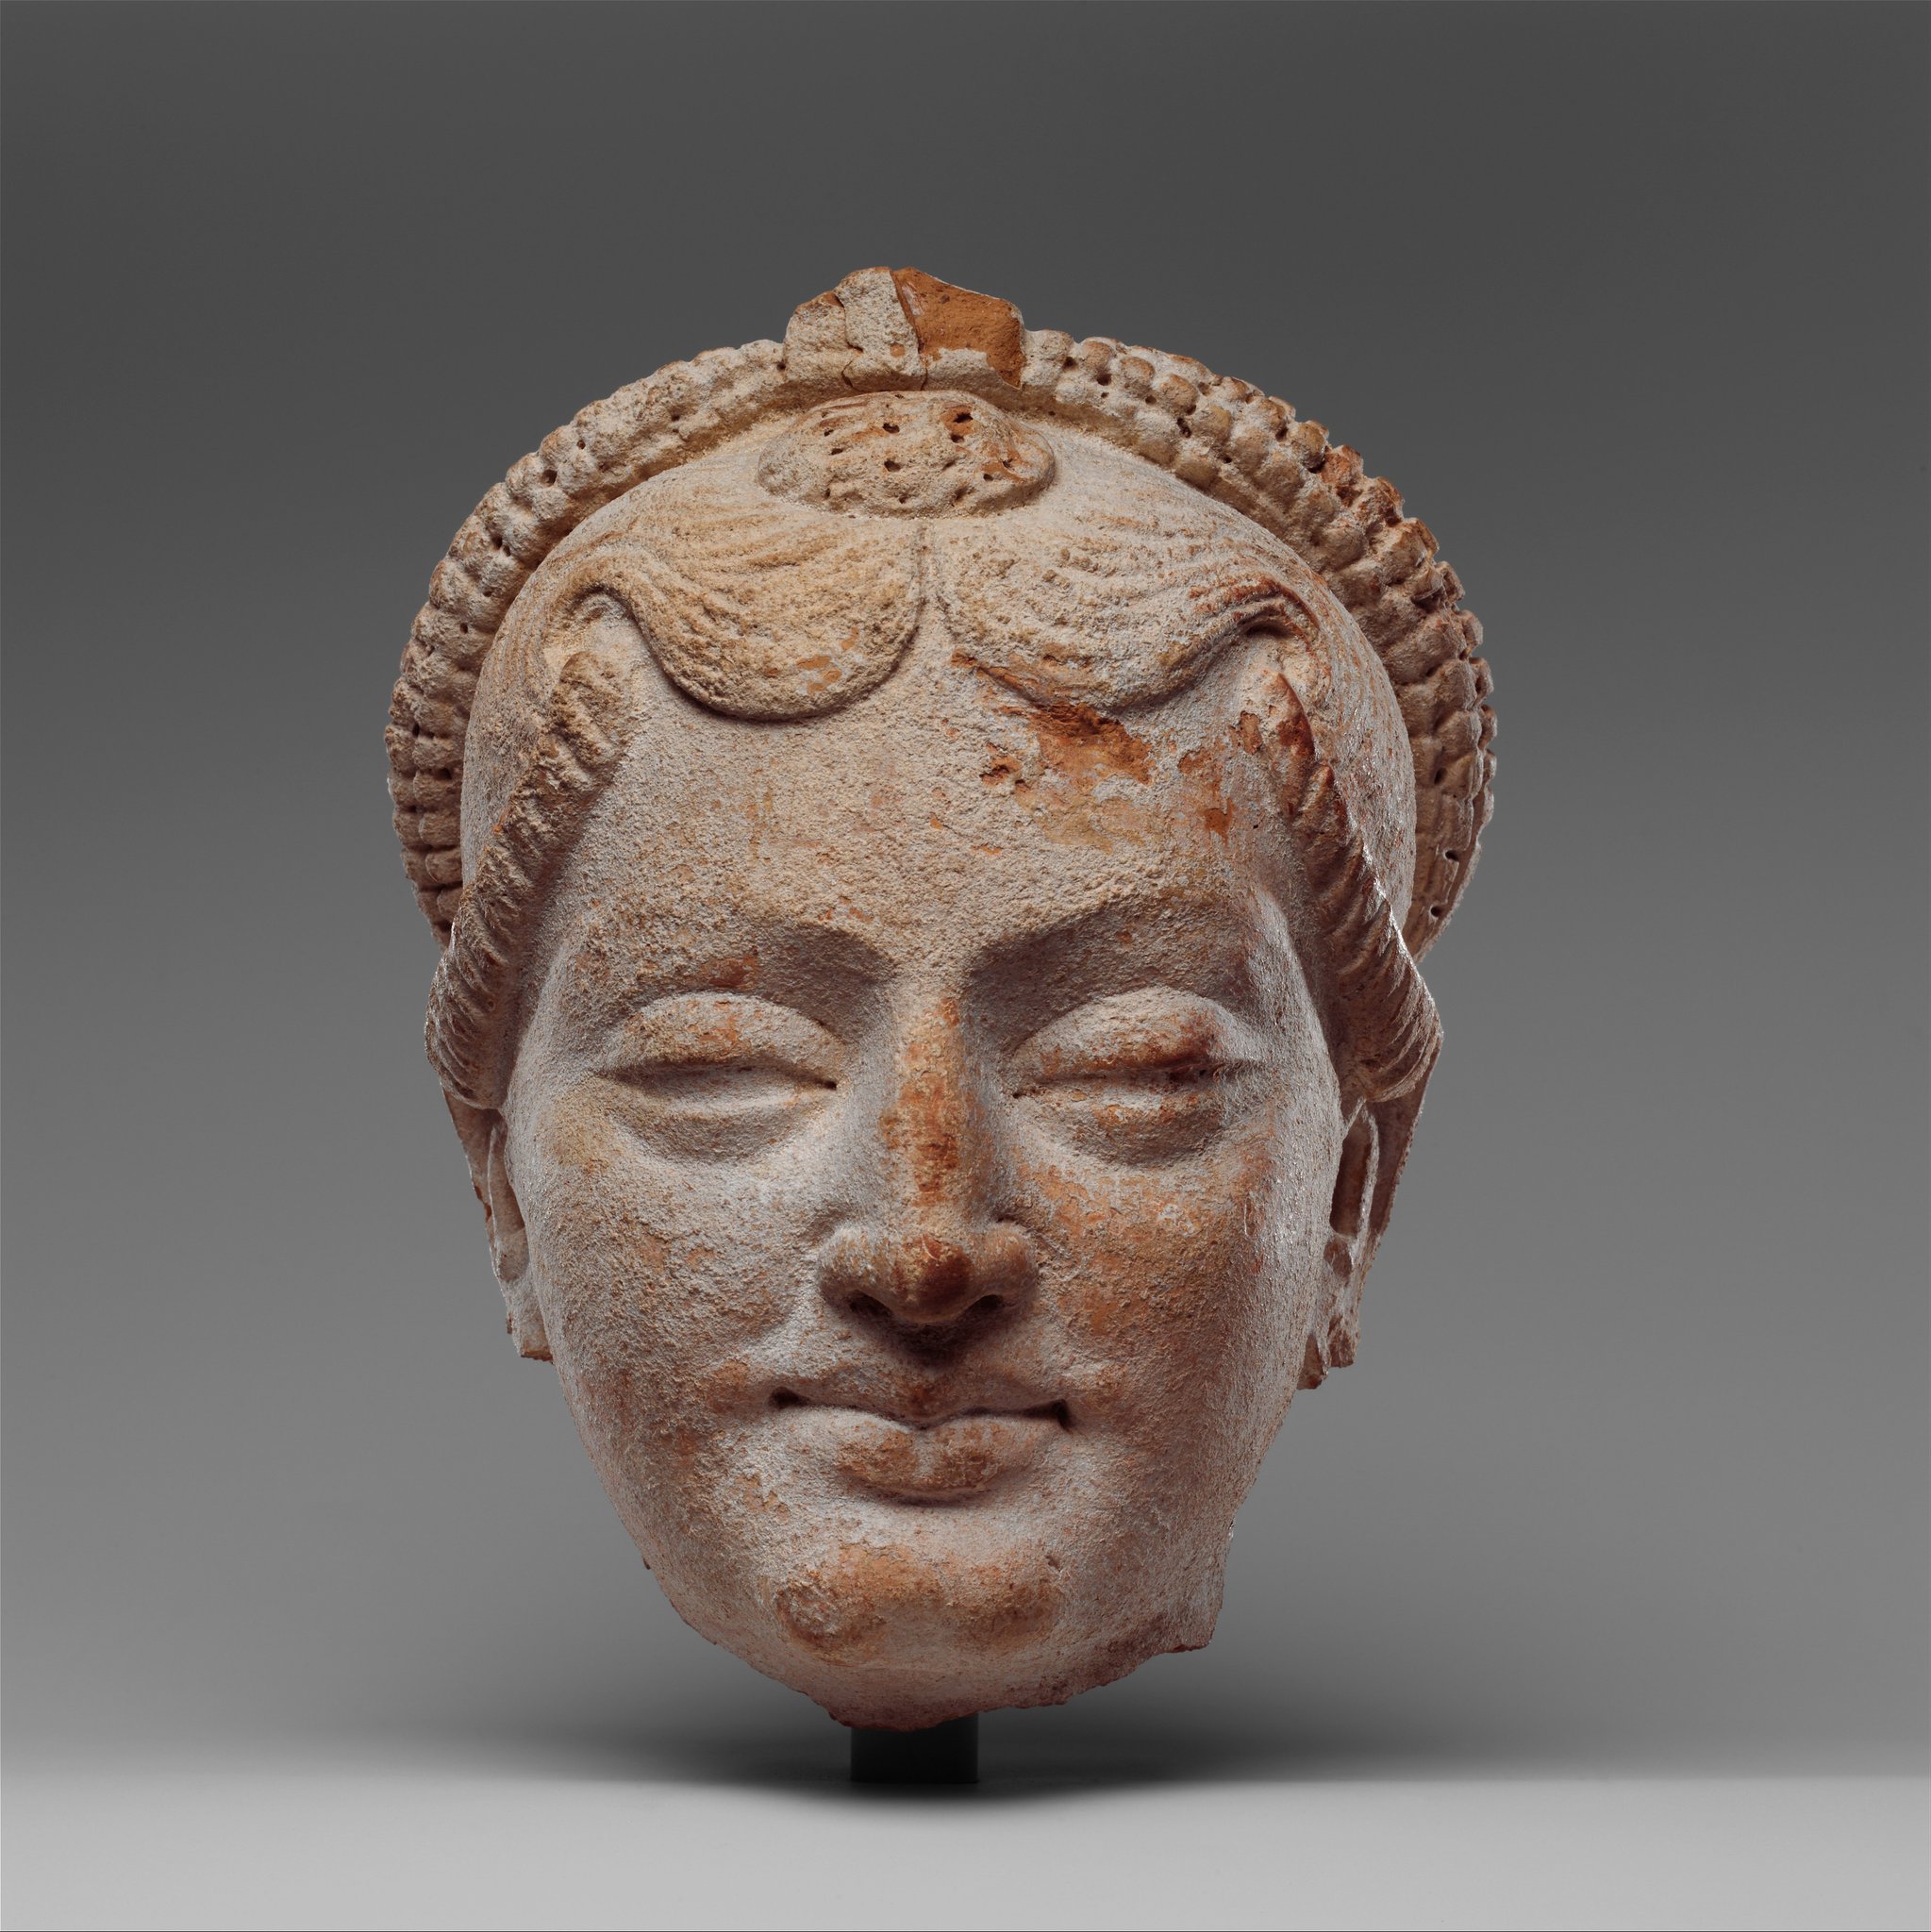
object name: head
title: Head of a Female Figure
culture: afghan or pakistani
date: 301-500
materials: terracotta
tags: gandhara,heads,women